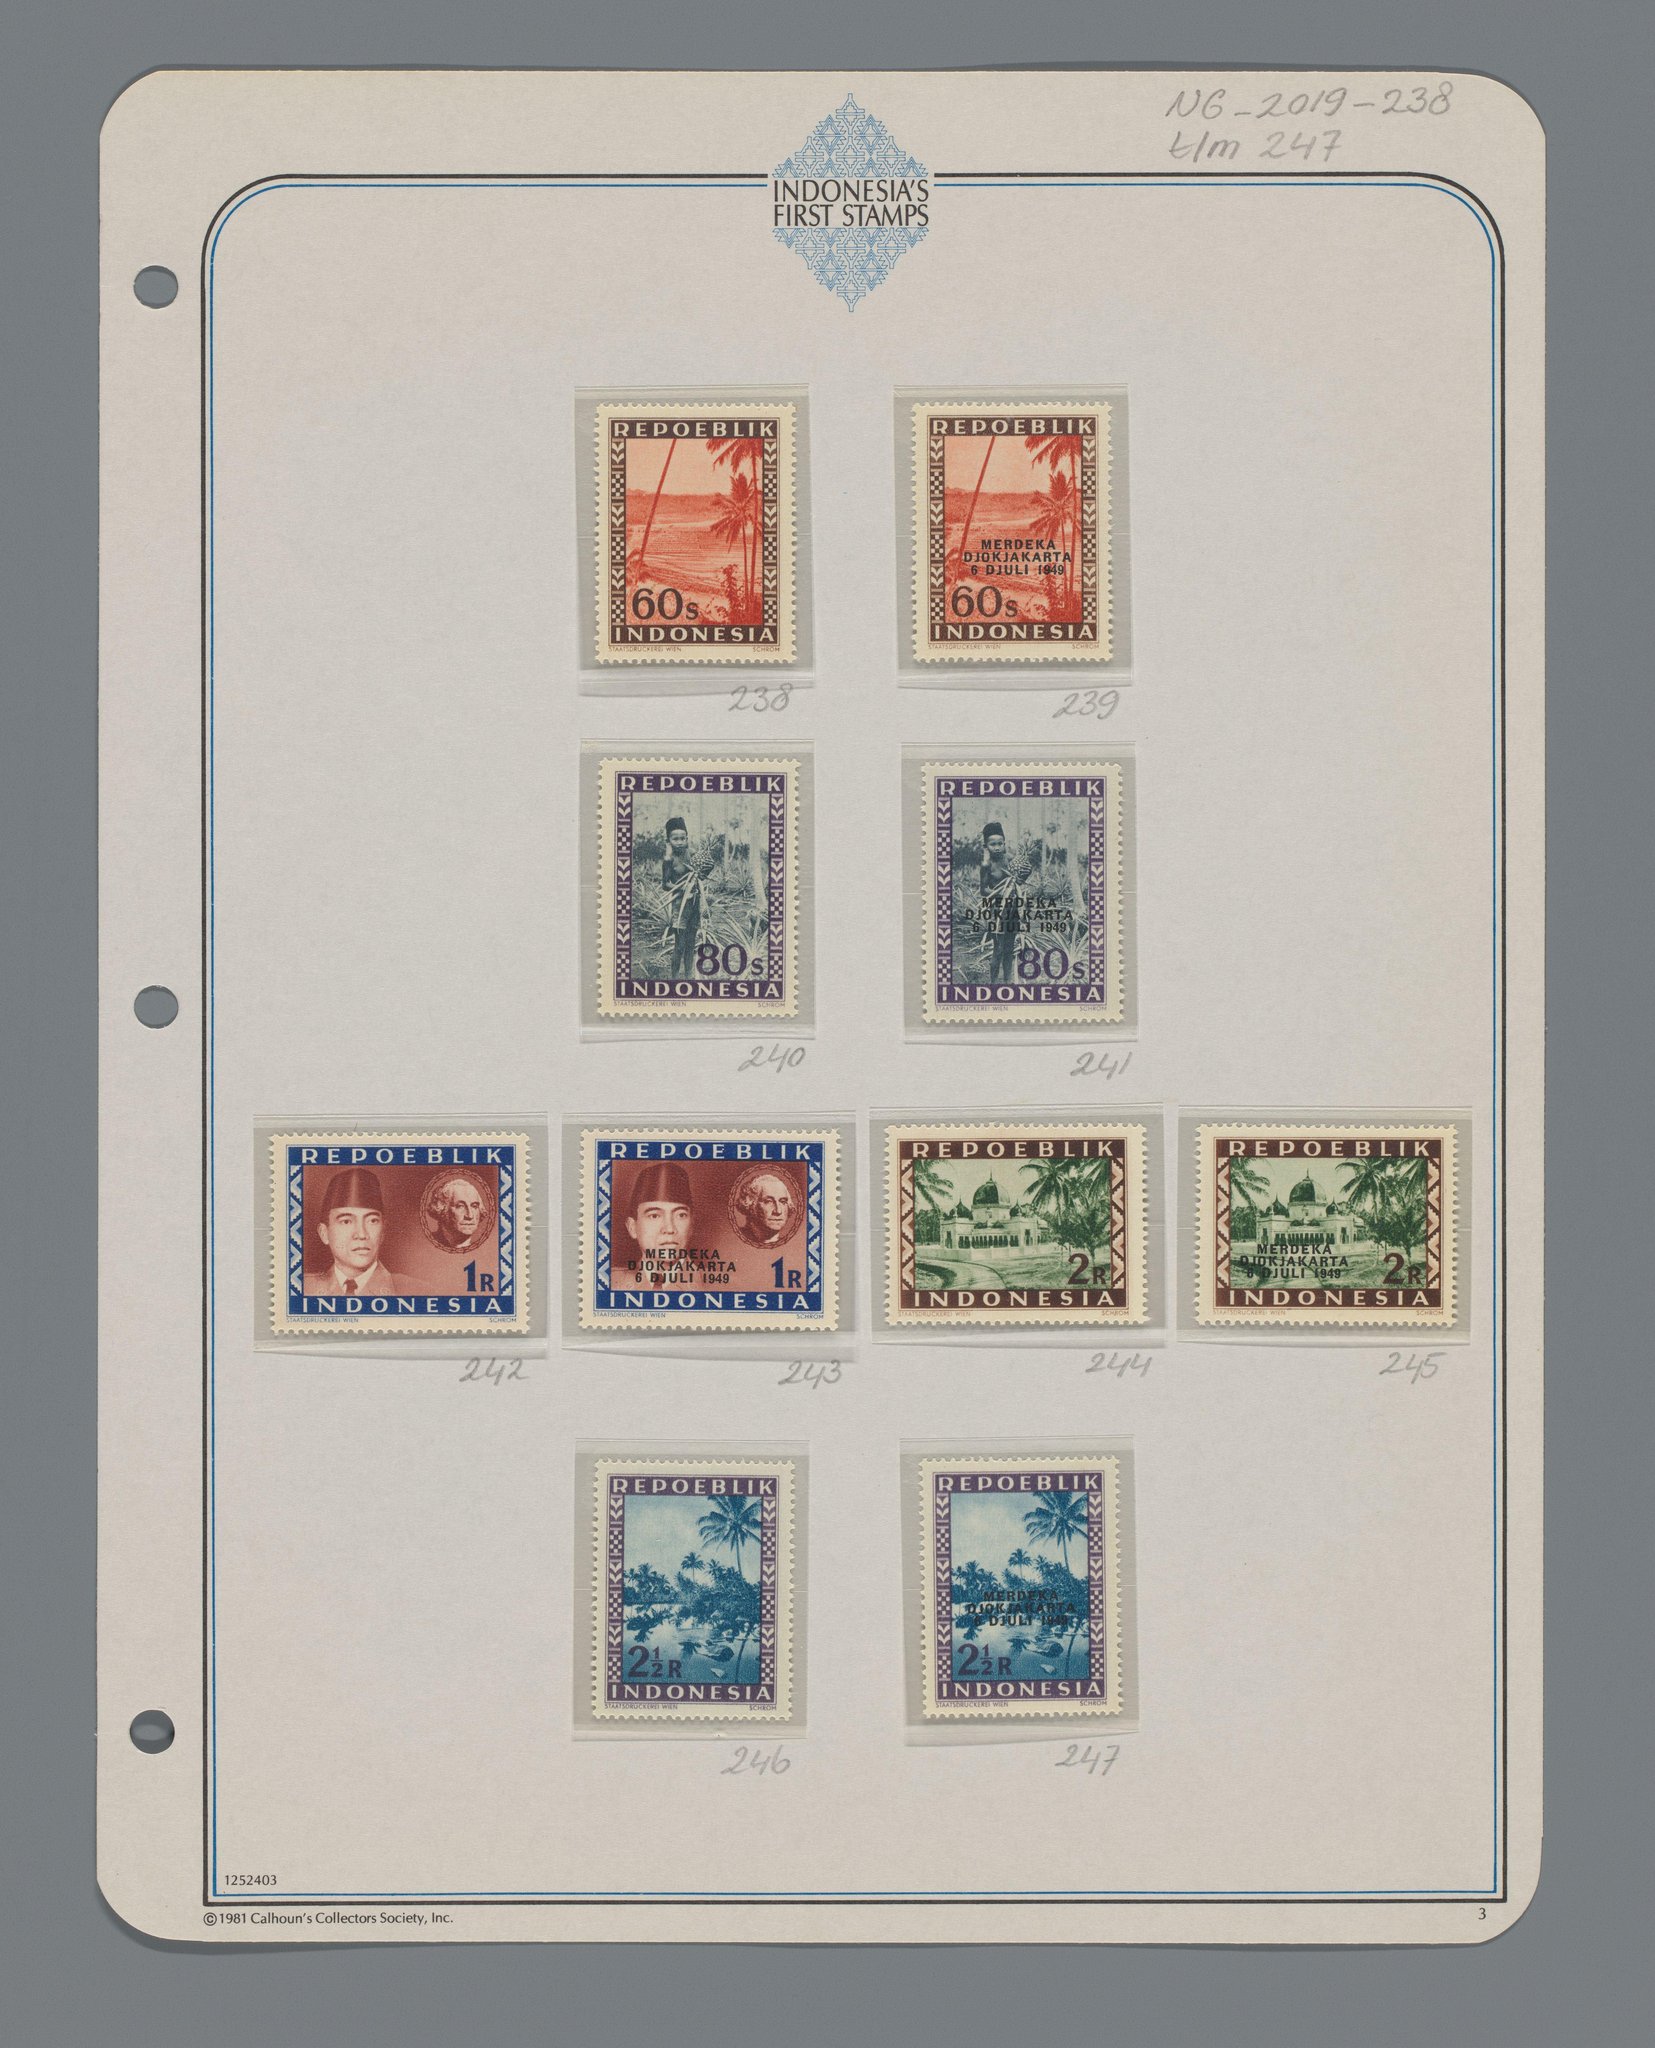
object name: postage stamp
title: Postzegel Republik Indonesia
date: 1949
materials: paper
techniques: photoaquatint, engraving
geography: philadelphia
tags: indonesia